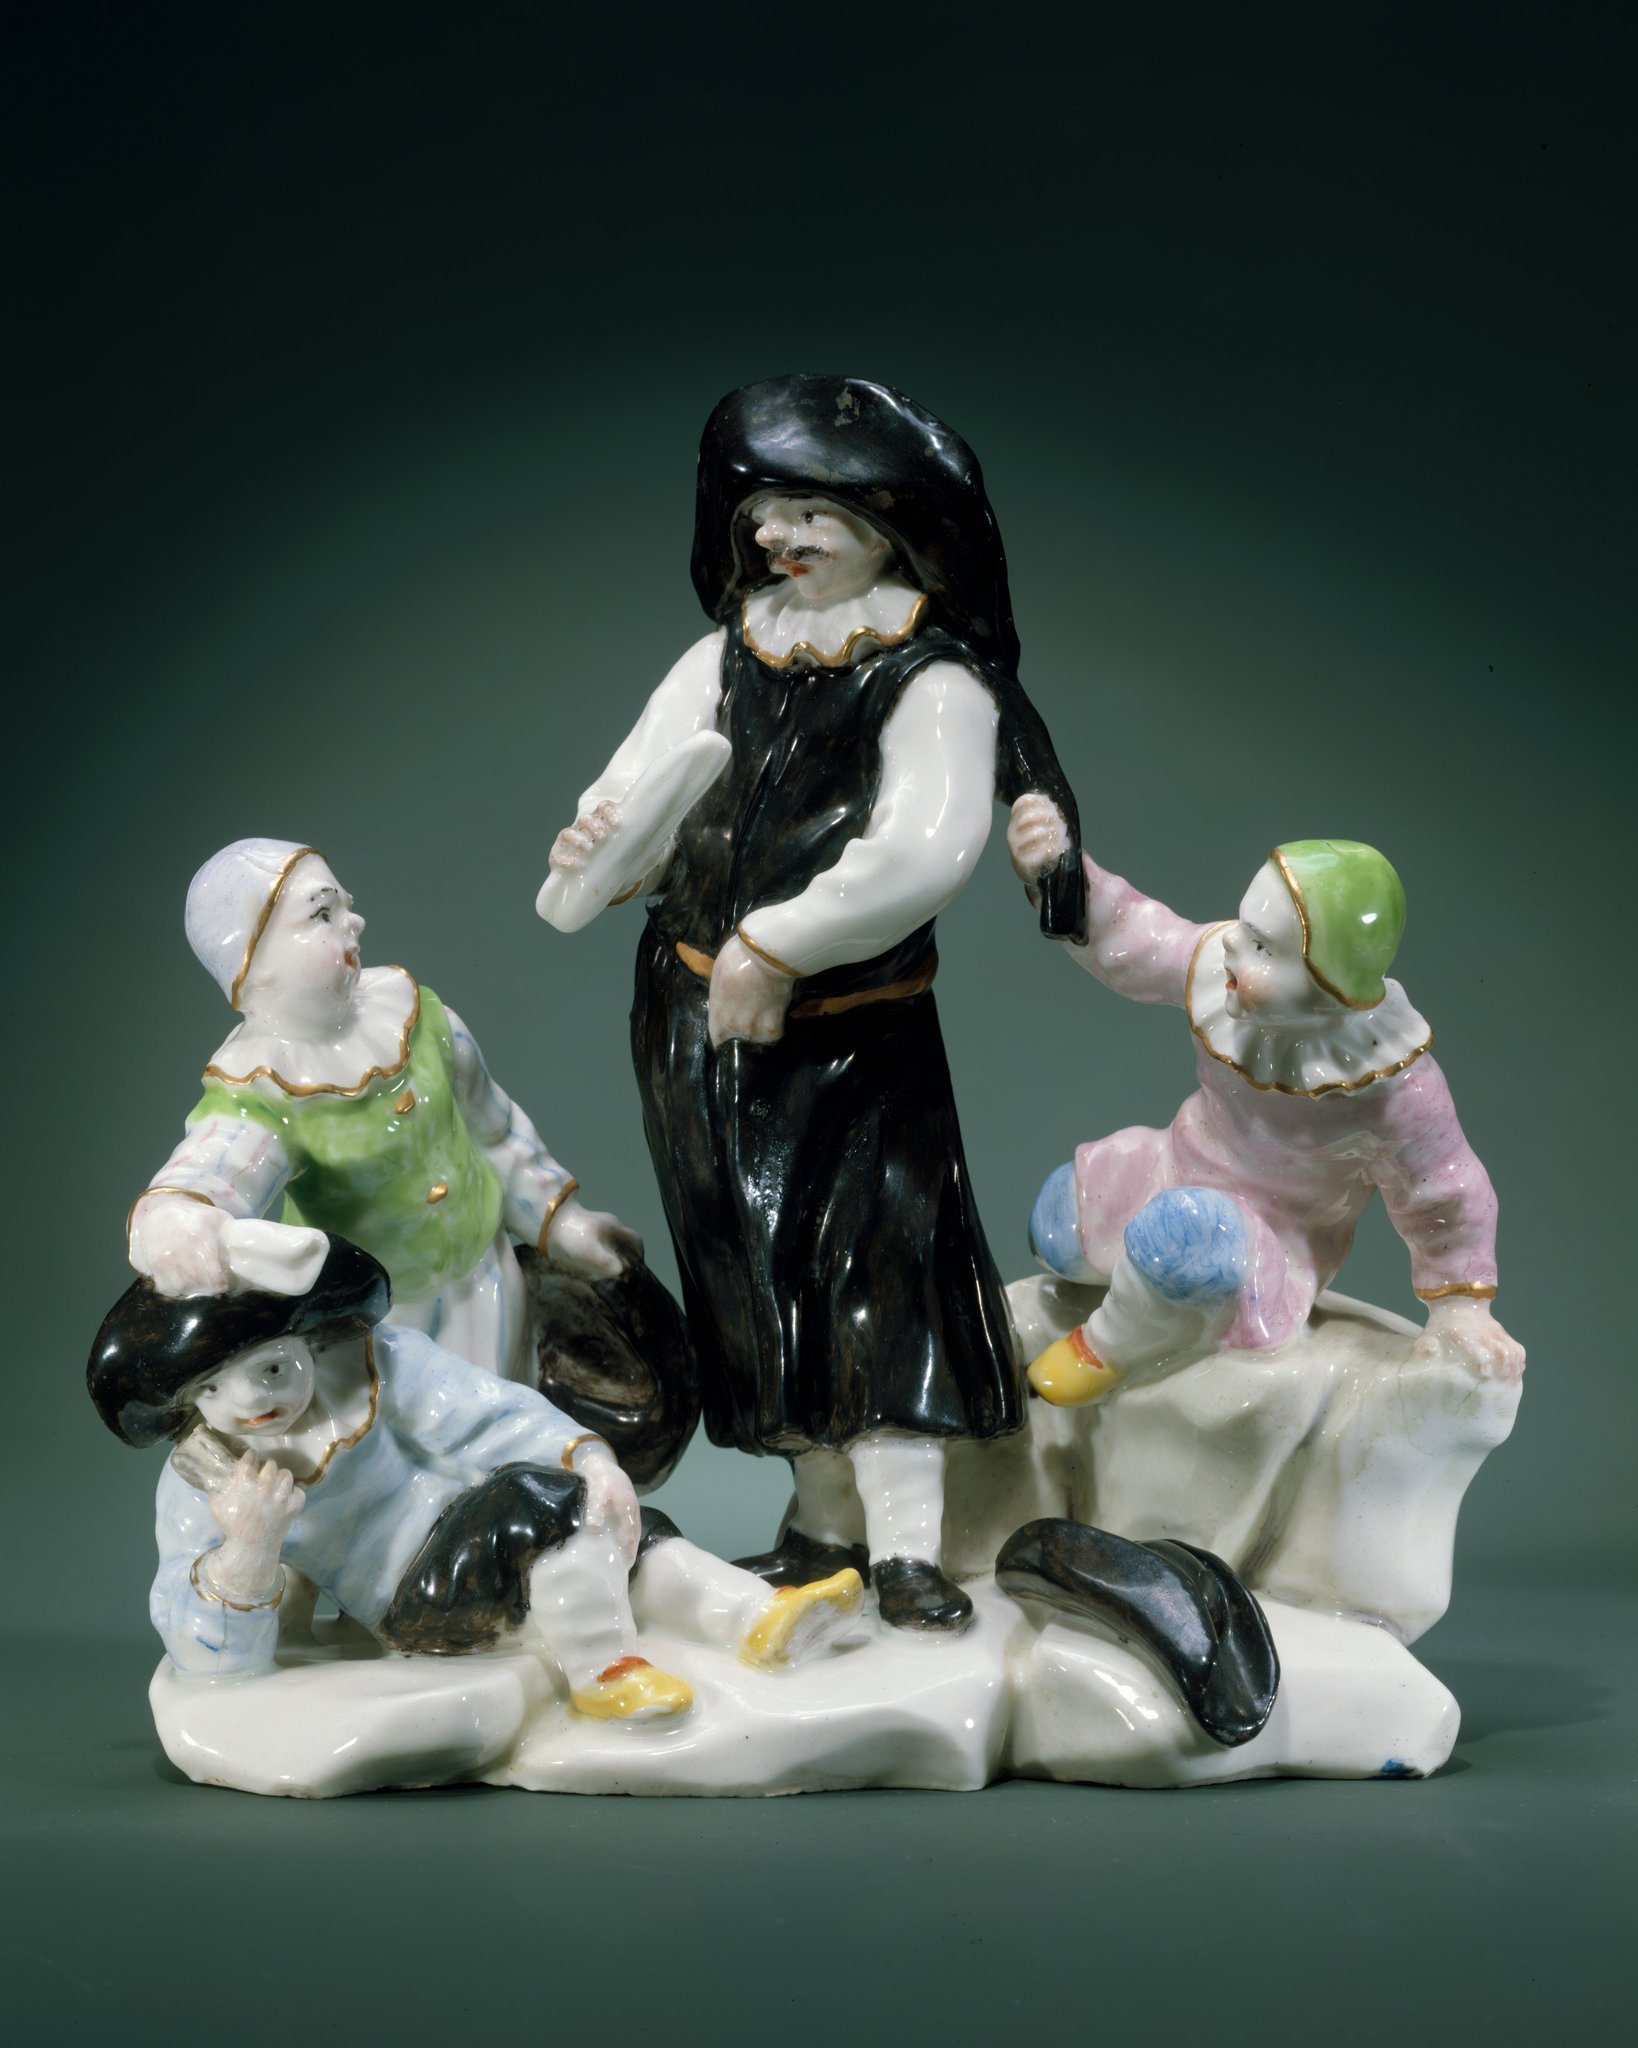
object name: group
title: Scaramouche with Children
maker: capodimonte porcelain manufactory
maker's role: manufactory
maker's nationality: italian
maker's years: 1740-1759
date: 1755-1759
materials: soft paste porcelain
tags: children,men,clowns